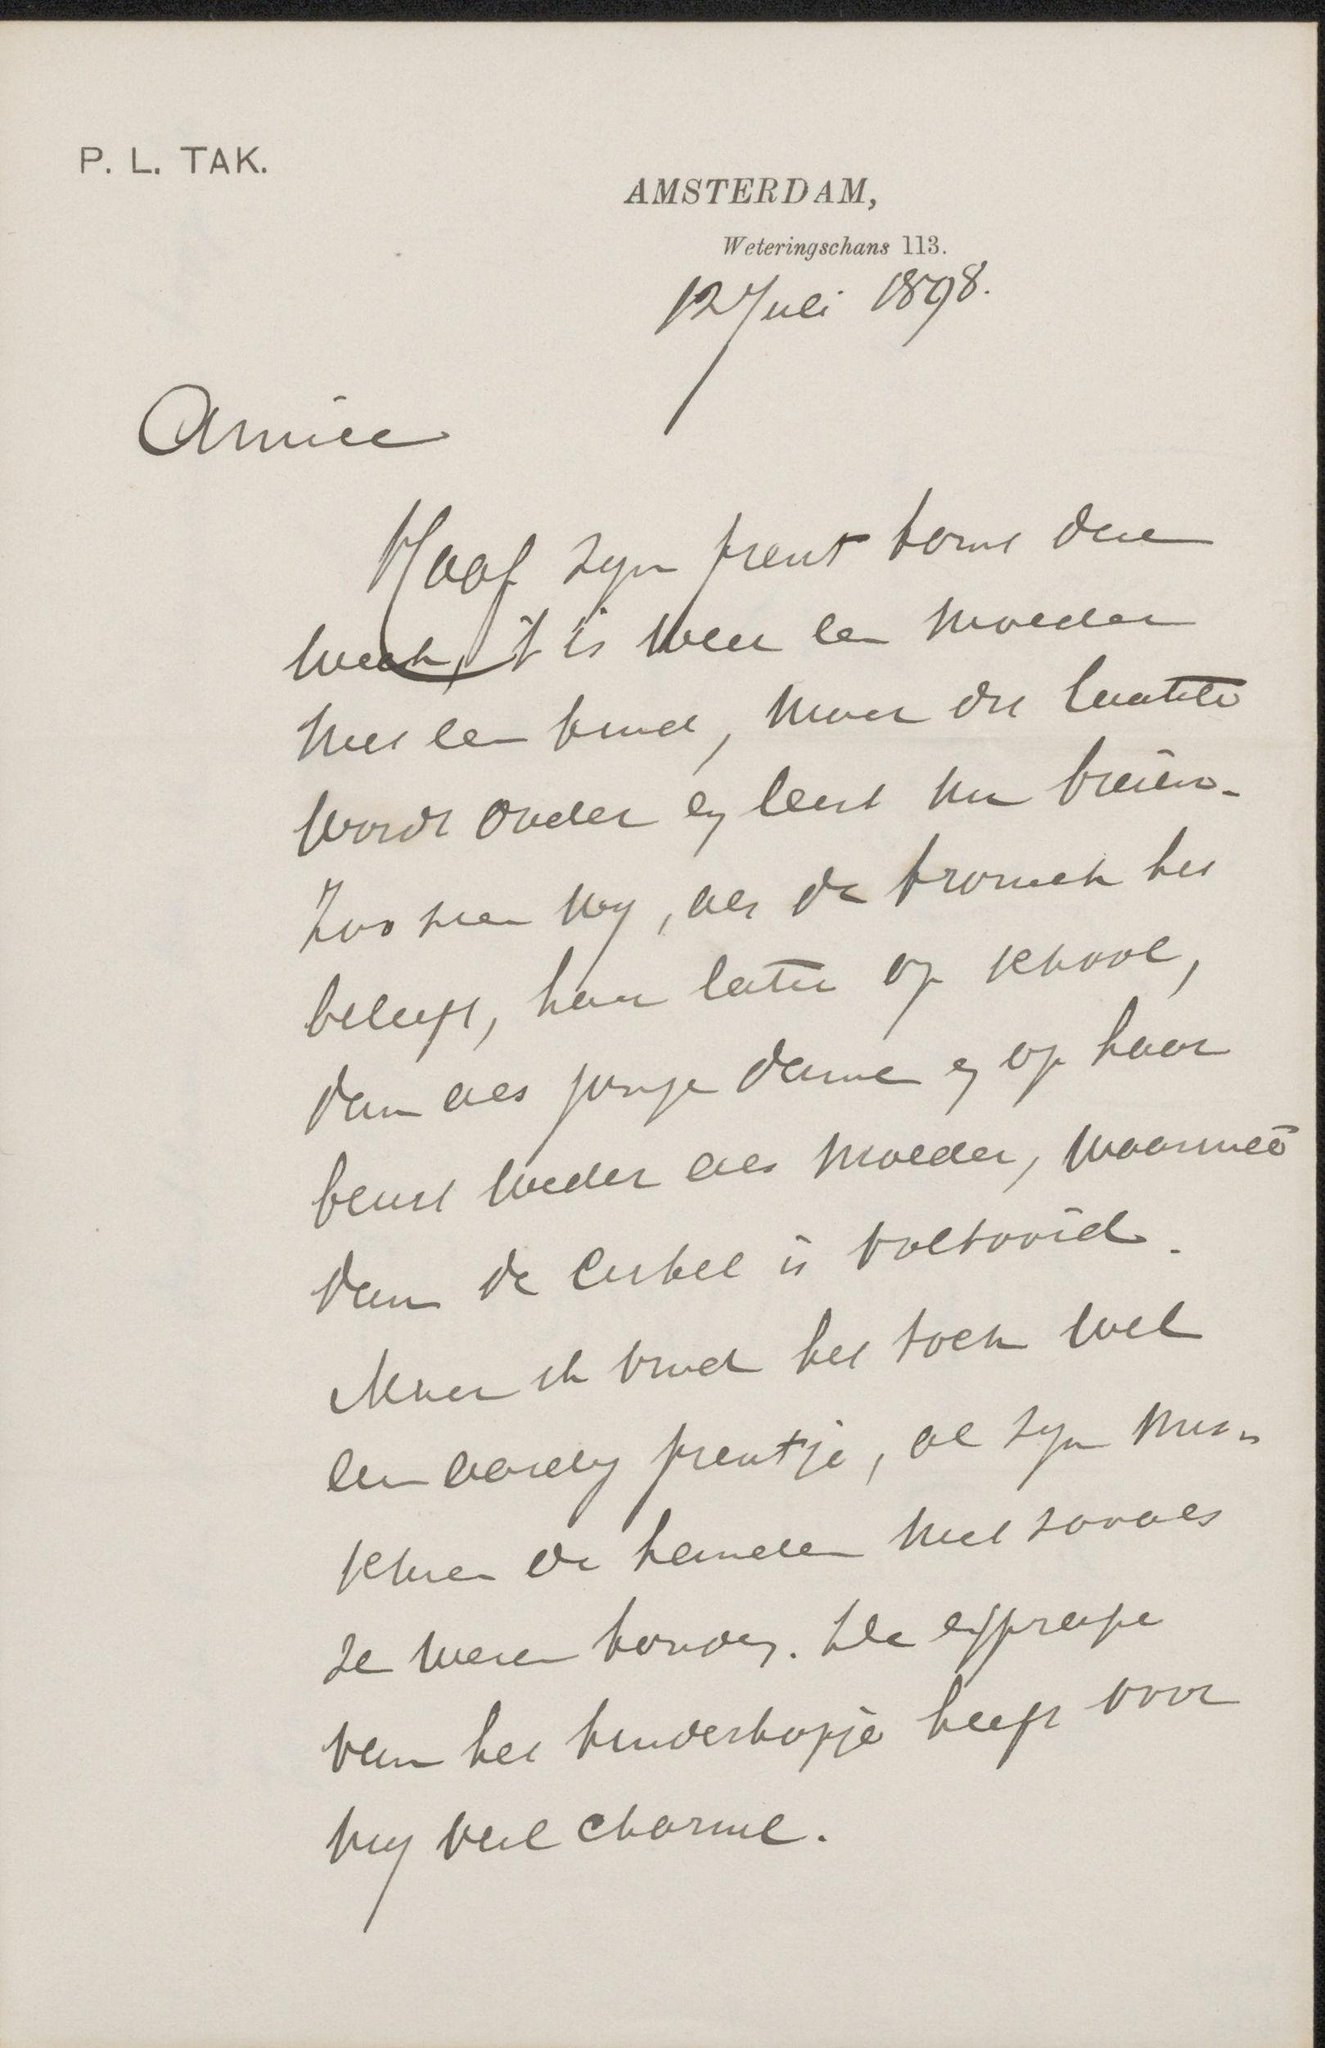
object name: letter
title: Brief aan Jan Veth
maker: pieter lodewijk tak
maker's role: politician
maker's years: 1848-1907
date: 1898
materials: ink, paper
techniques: pen, printing, writing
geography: amsterdam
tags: dordrecht, amsterdam, painter, draughtsman, designer, jan veth, hendrik johannes haverman, frans coenen (1866-1936), berlin, wilhelm von bode, jan kalff, andré jolles, the graphic arts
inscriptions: collector's mark: ‘RPK’, watermark